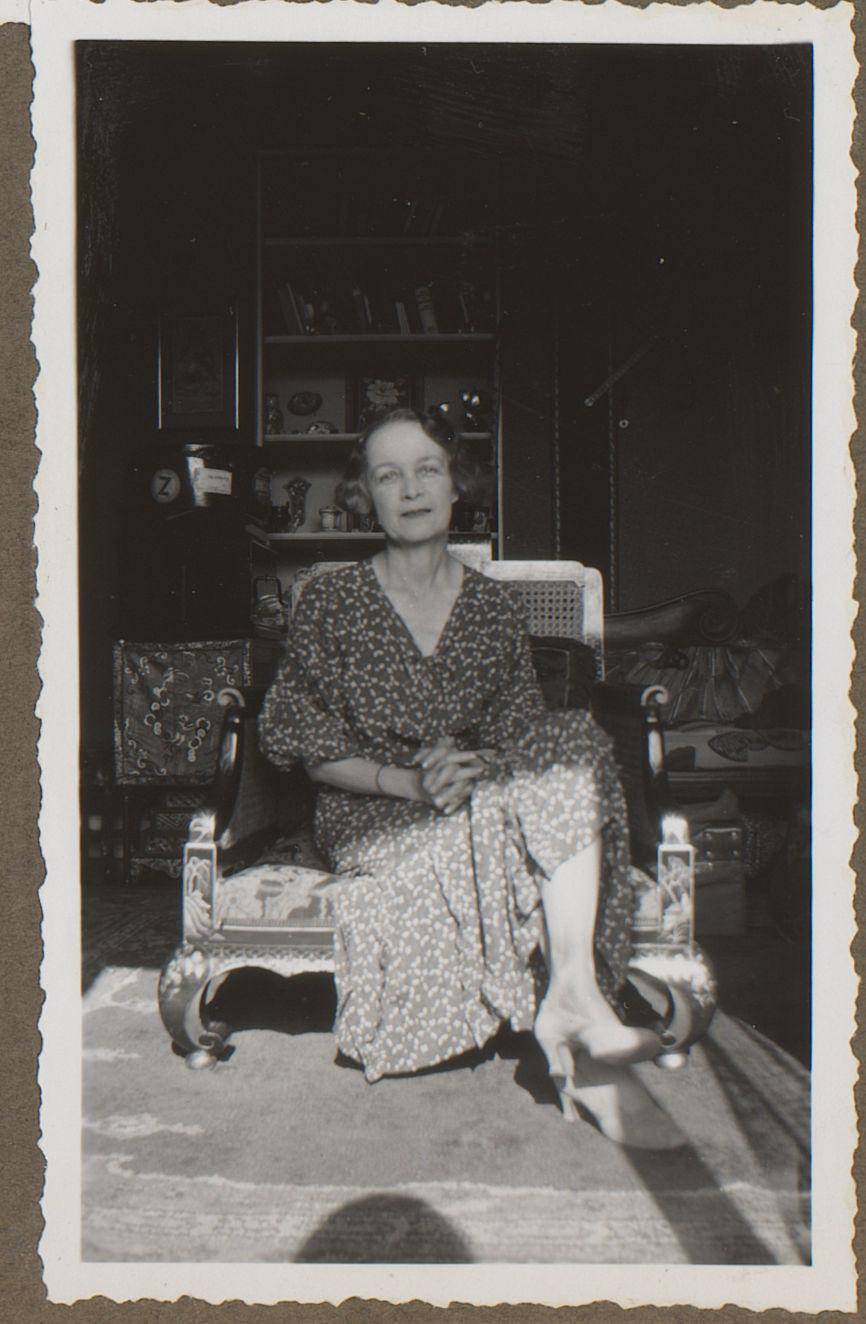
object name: album leaf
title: Portret van een vrouw in een stoel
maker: Anonymous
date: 1934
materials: paper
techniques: gelatin silver print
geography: netherlands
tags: historical persons not known by name - bb - woman